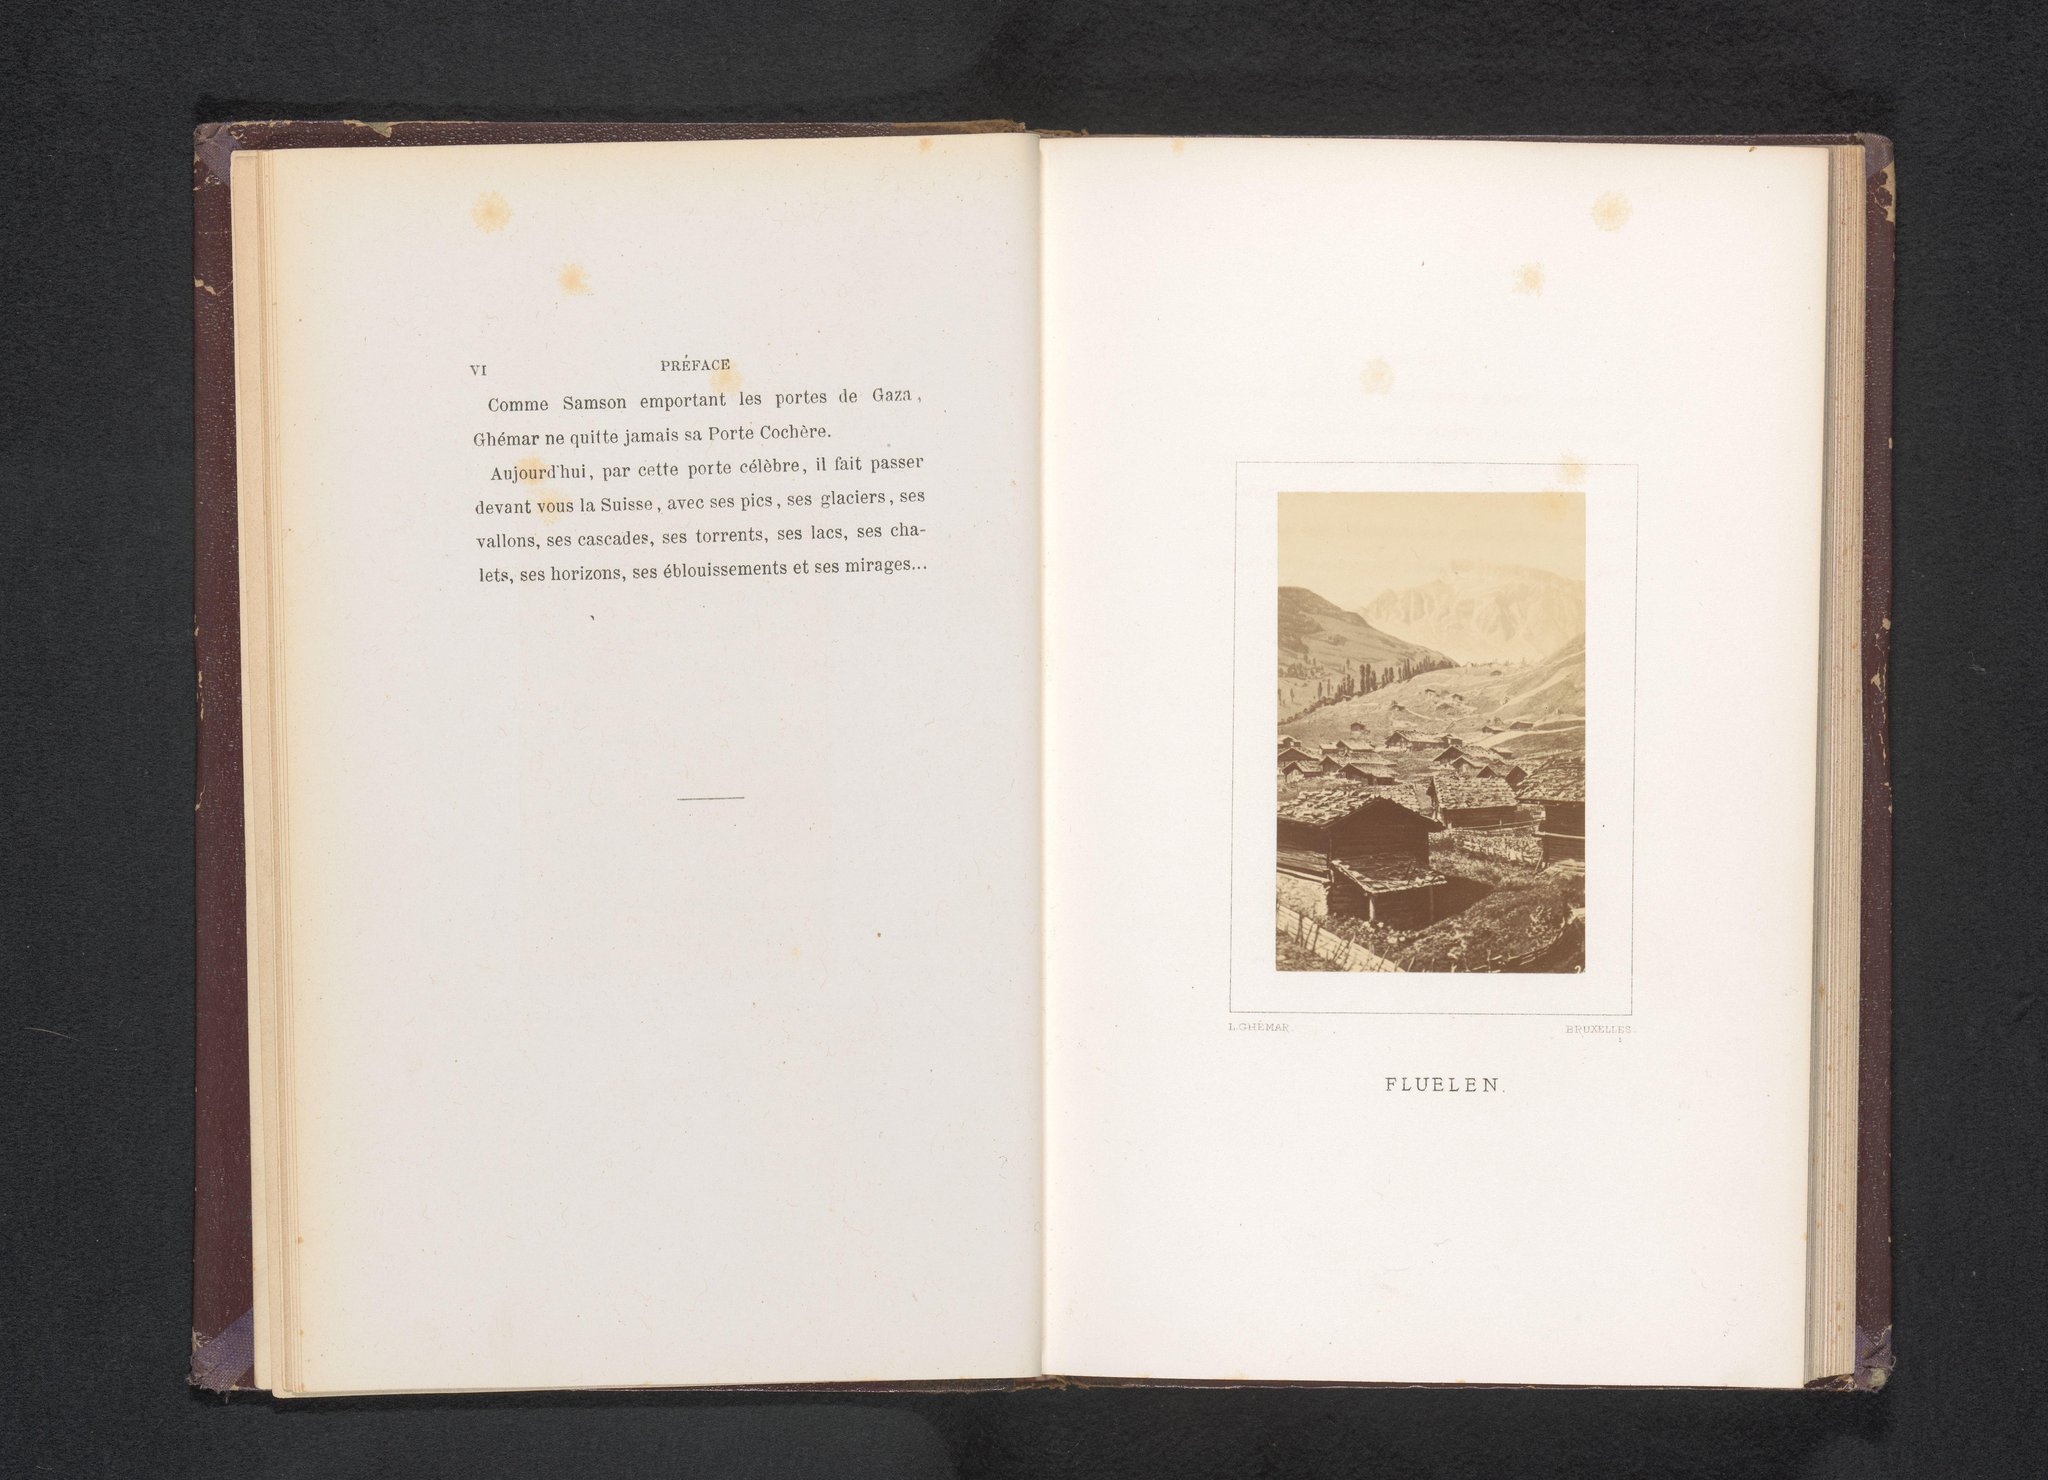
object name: photograph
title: Fluelen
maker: louis ghémar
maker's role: draughtsman, print maker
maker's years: 1819-1873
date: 1863-1868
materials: photographic support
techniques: albumen print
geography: flüelen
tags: city-view in general; 'veduta', mountains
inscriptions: inscription: ‘Bruxelles’